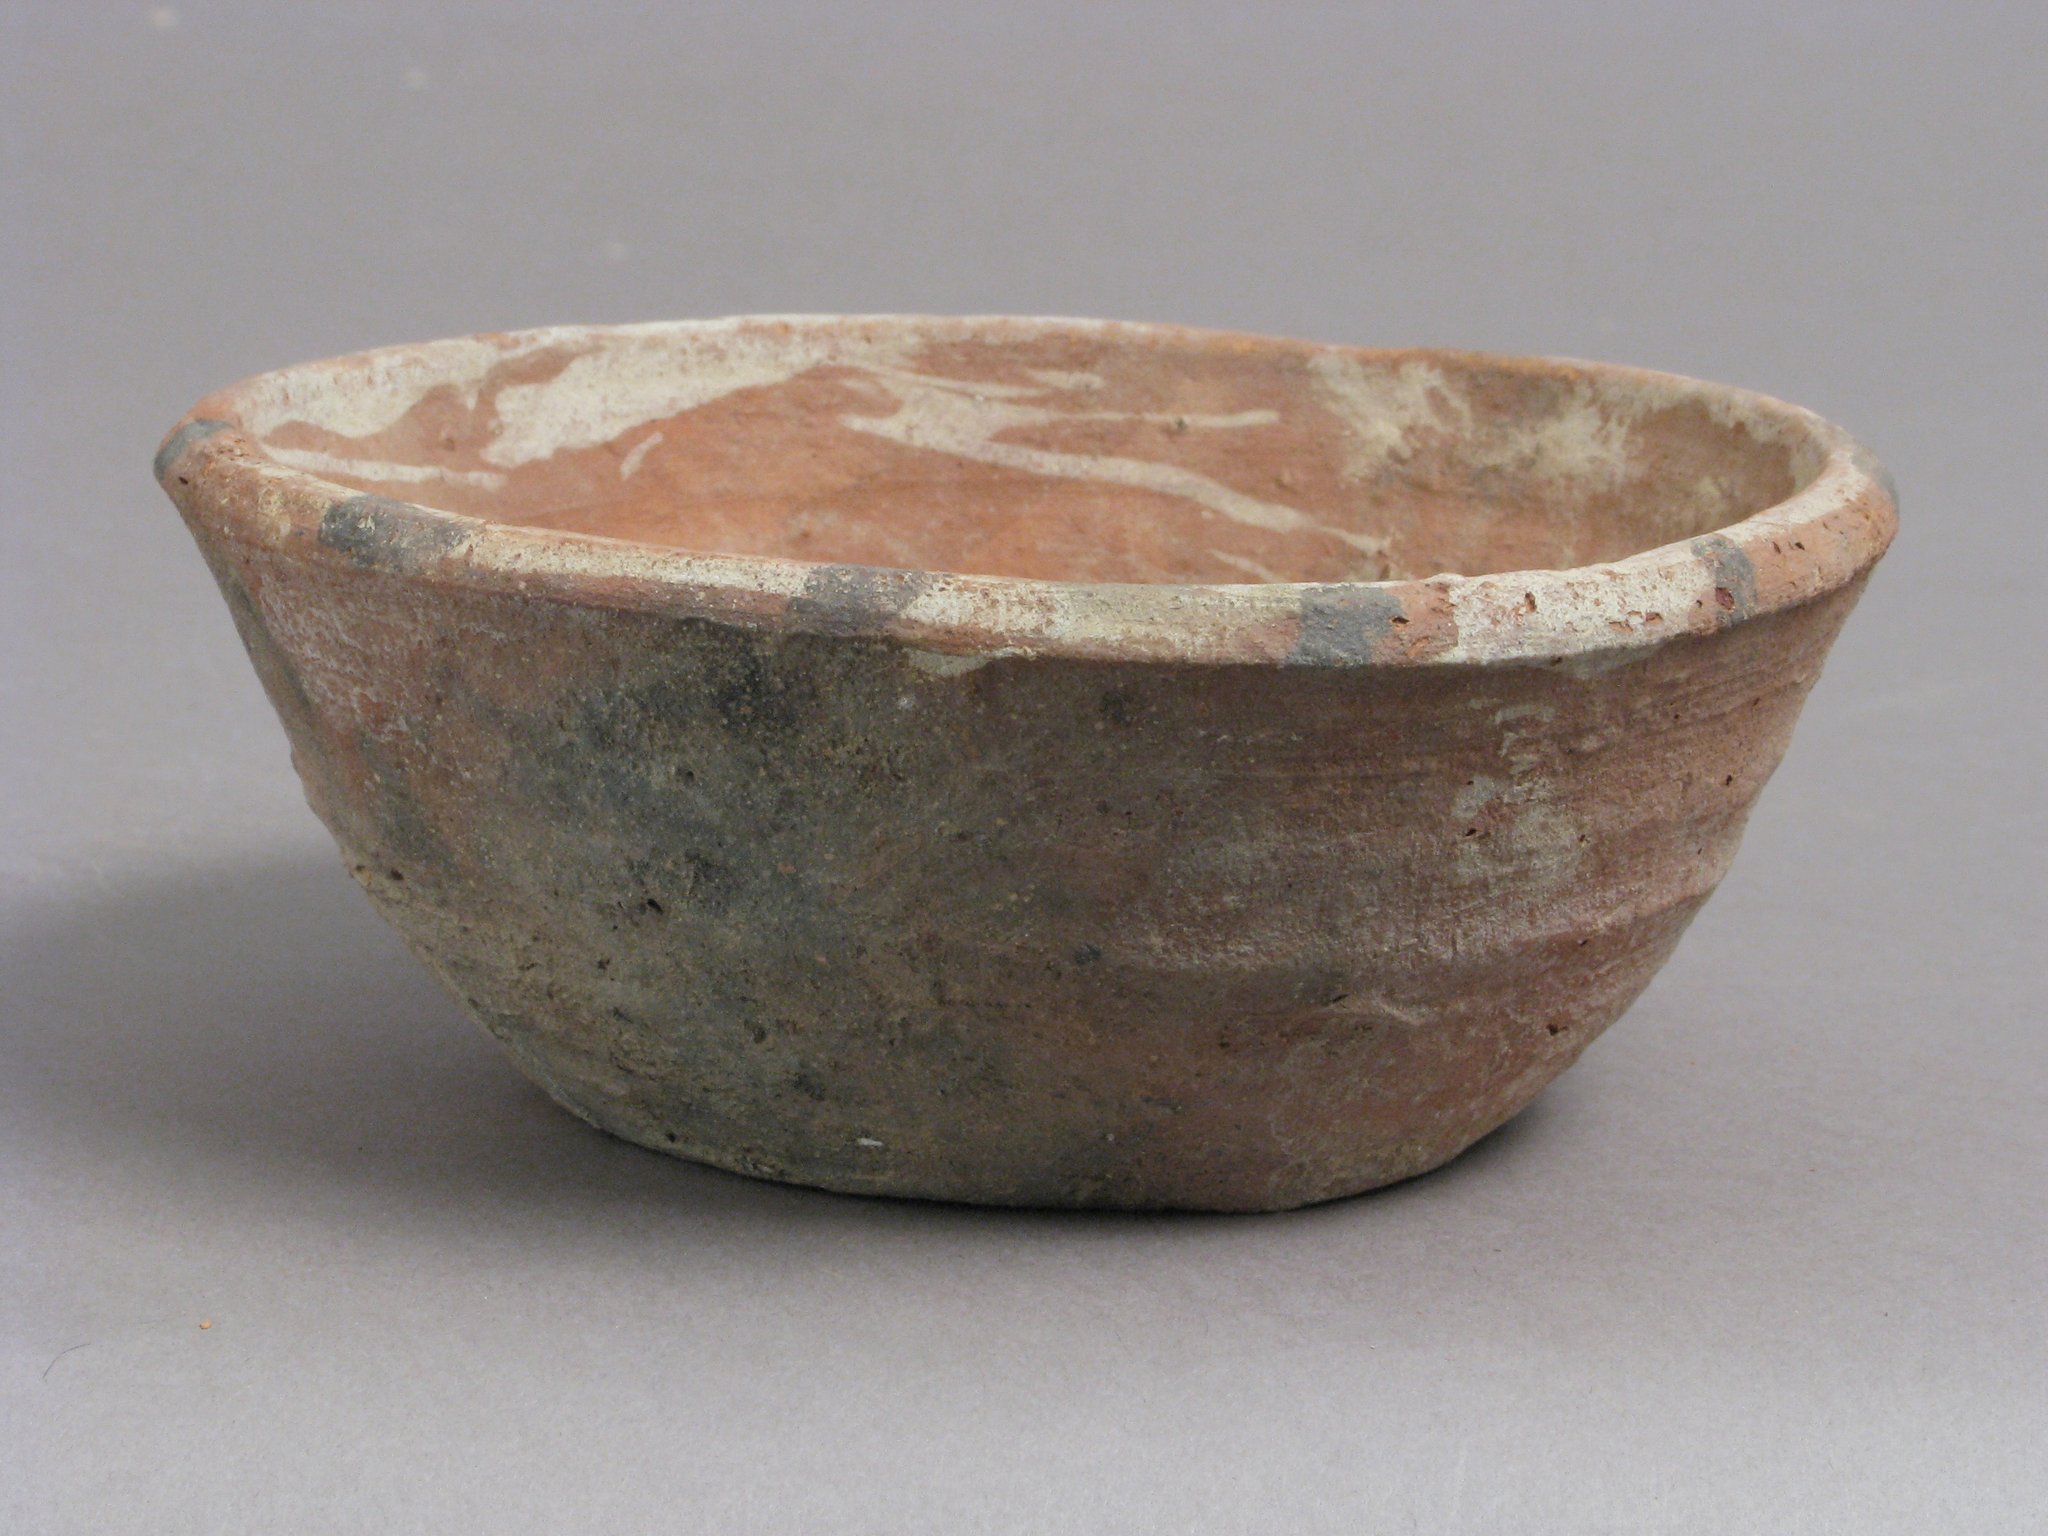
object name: bowl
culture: coptic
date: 301-700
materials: earthenware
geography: egypt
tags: bowls